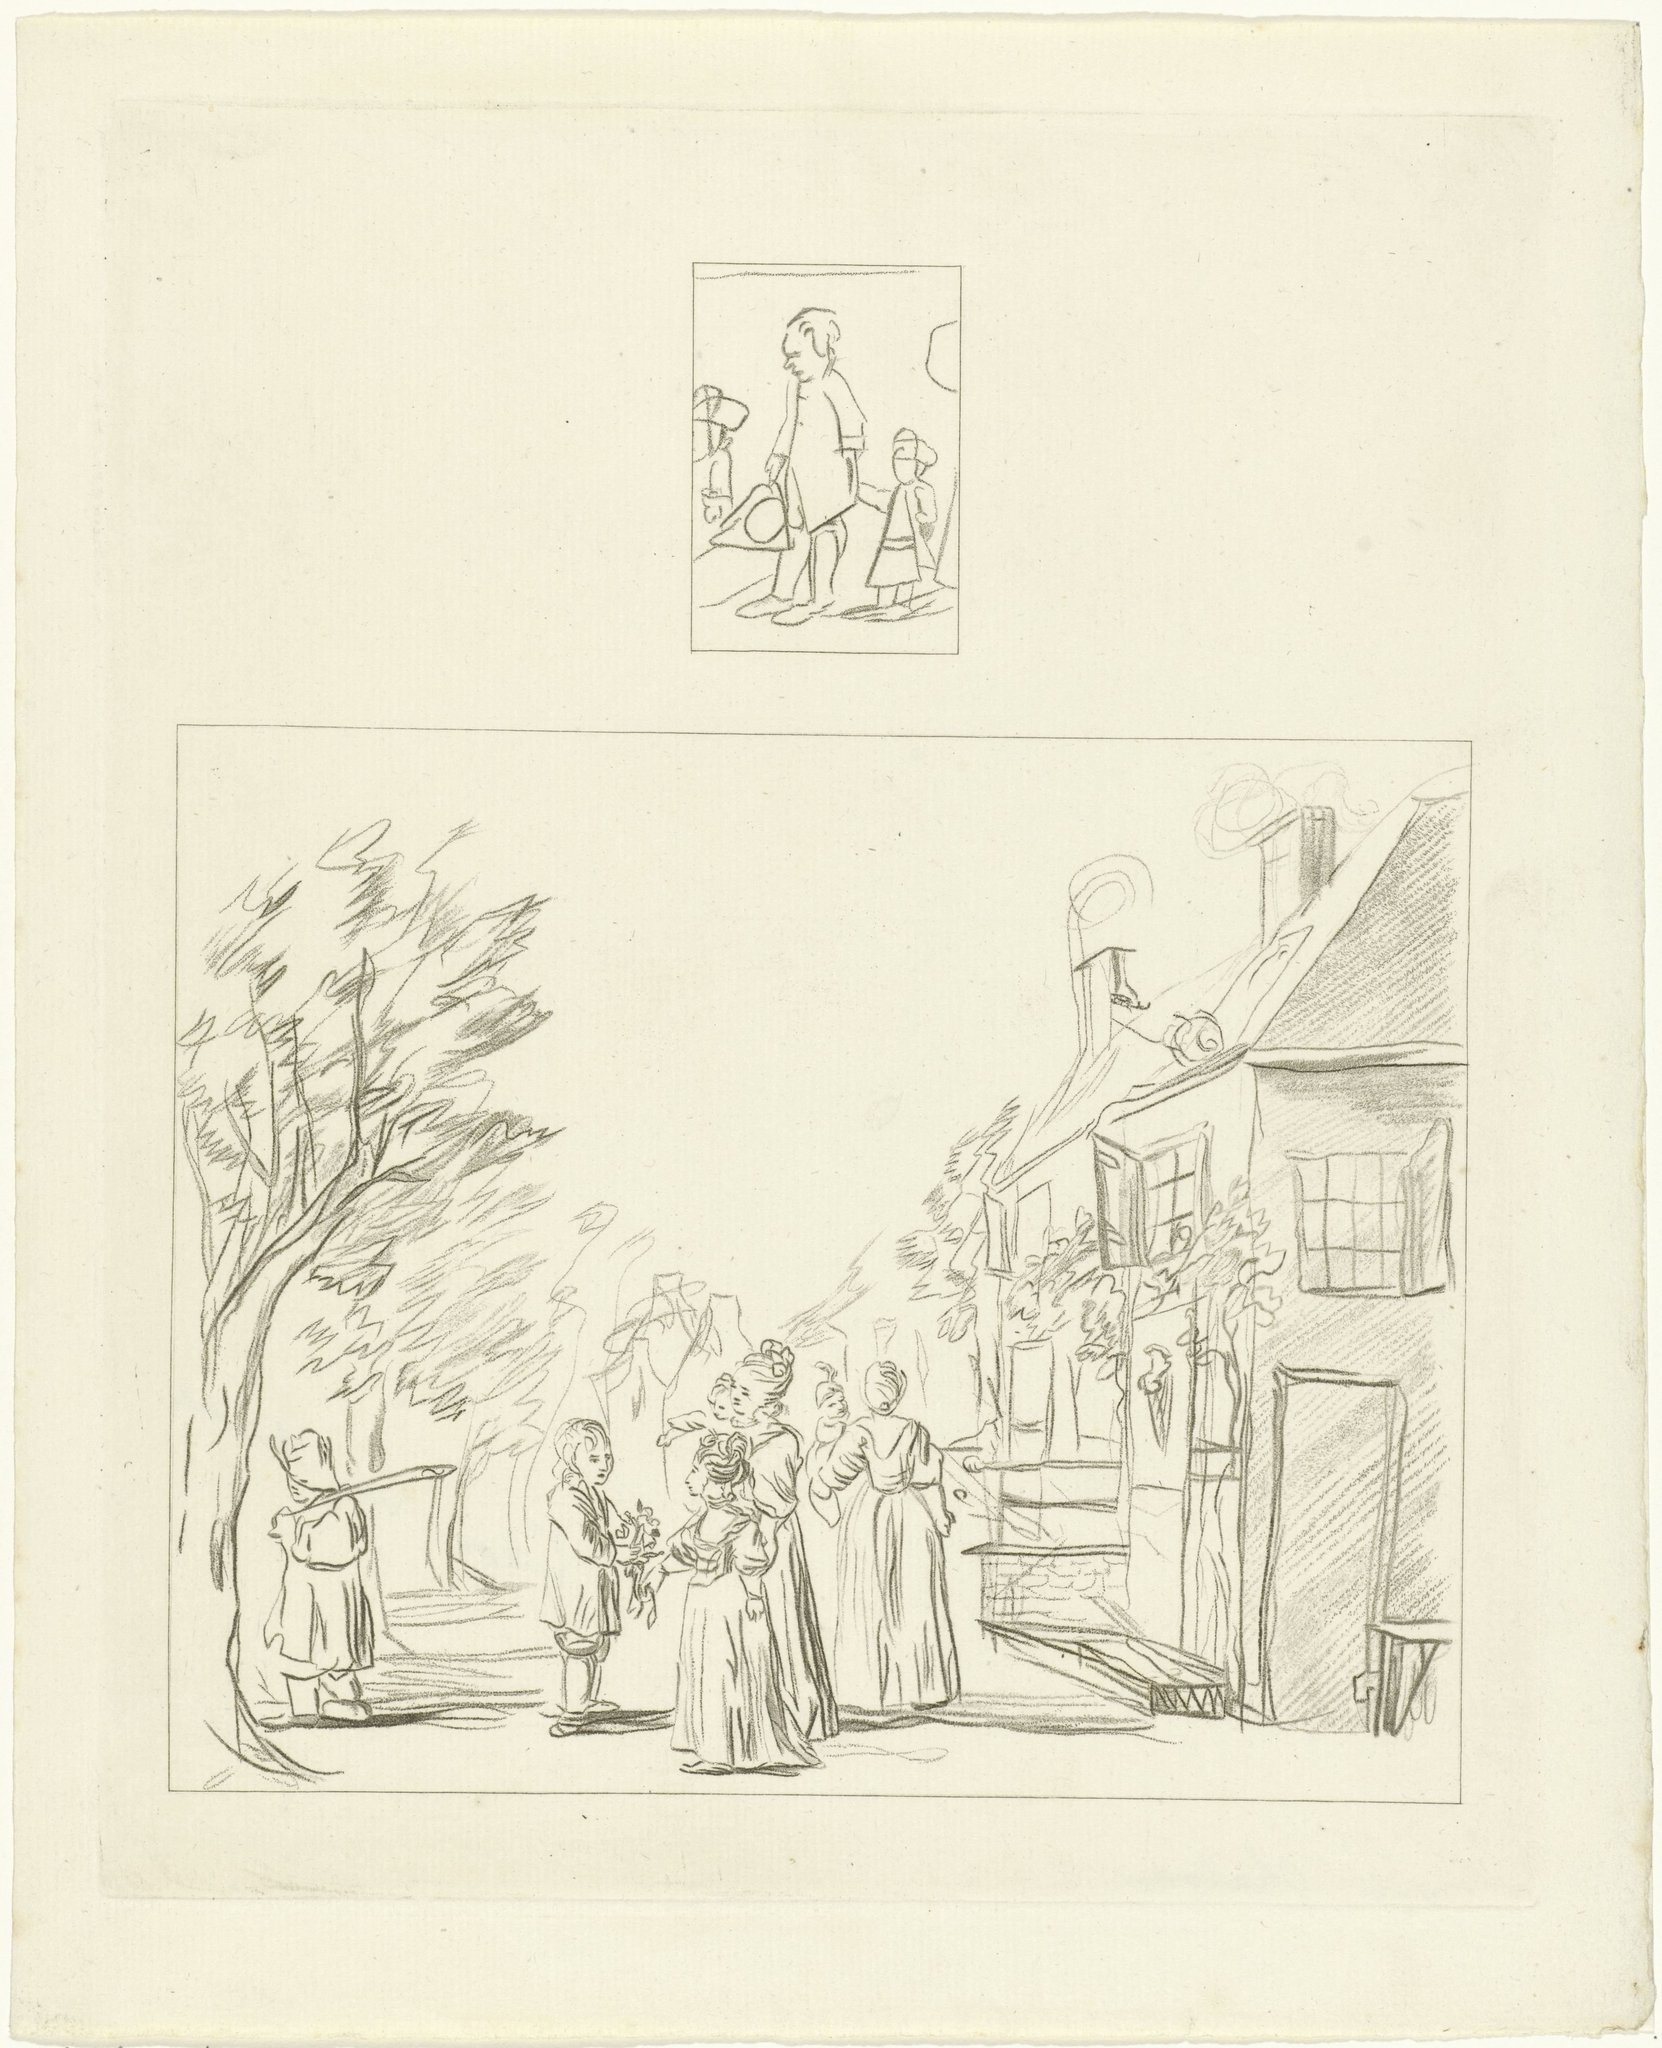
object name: print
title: Jongetje met klein kindje / Twee moeders en vijf kinderen bij buitenhuis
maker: cornelis ploos van amstel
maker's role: draughtsman, print maker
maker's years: 1726-1798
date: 1736-1798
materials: paper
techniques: printmaking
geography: amsterdam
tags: leading someone by the hand or wrist - aa - both arms or hands, child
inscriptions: collector's mark: Lugt 2228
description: Twee voorstellingen. Boven een jongetje met een klein meisje aan de hand. Onder moeders en kinderen bij een huis.